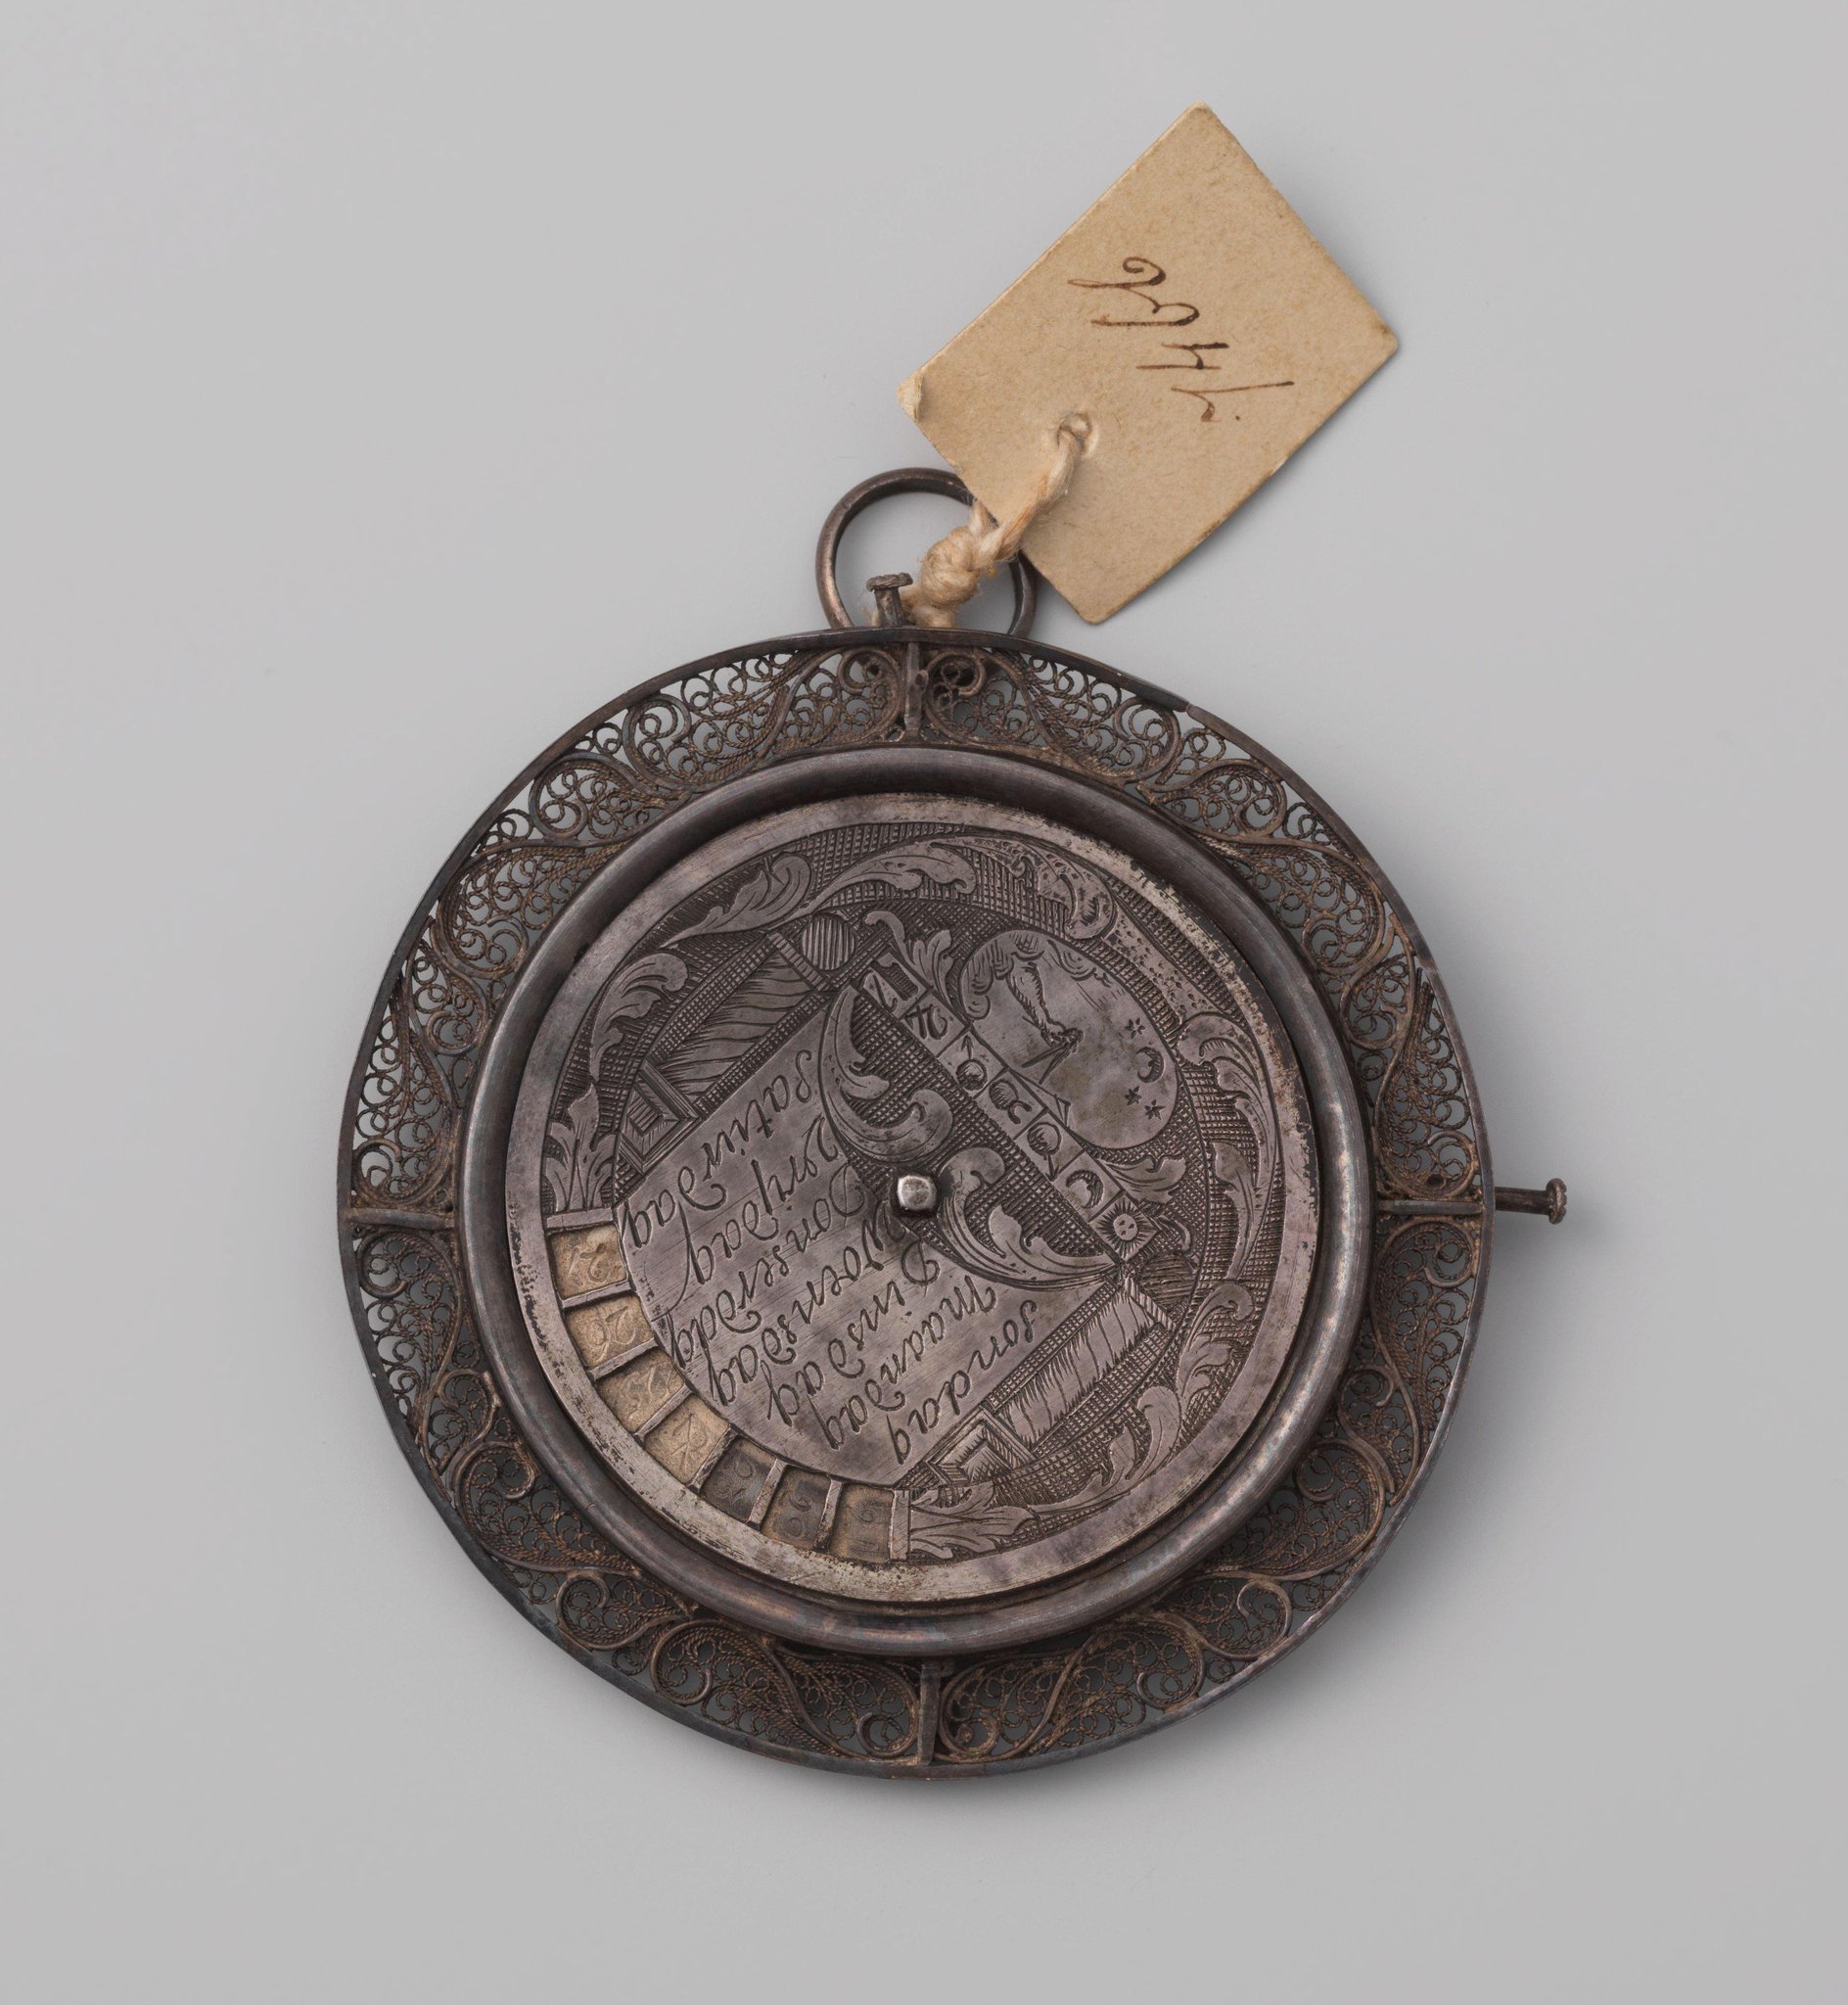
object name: calendar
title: Dag- en maandwijzer van zilver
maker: Anonymous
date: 1400-1950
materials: silver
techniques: filigree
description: Dag- en maandwijzer van zilver, gezet in een filigrein-zilveren rand.